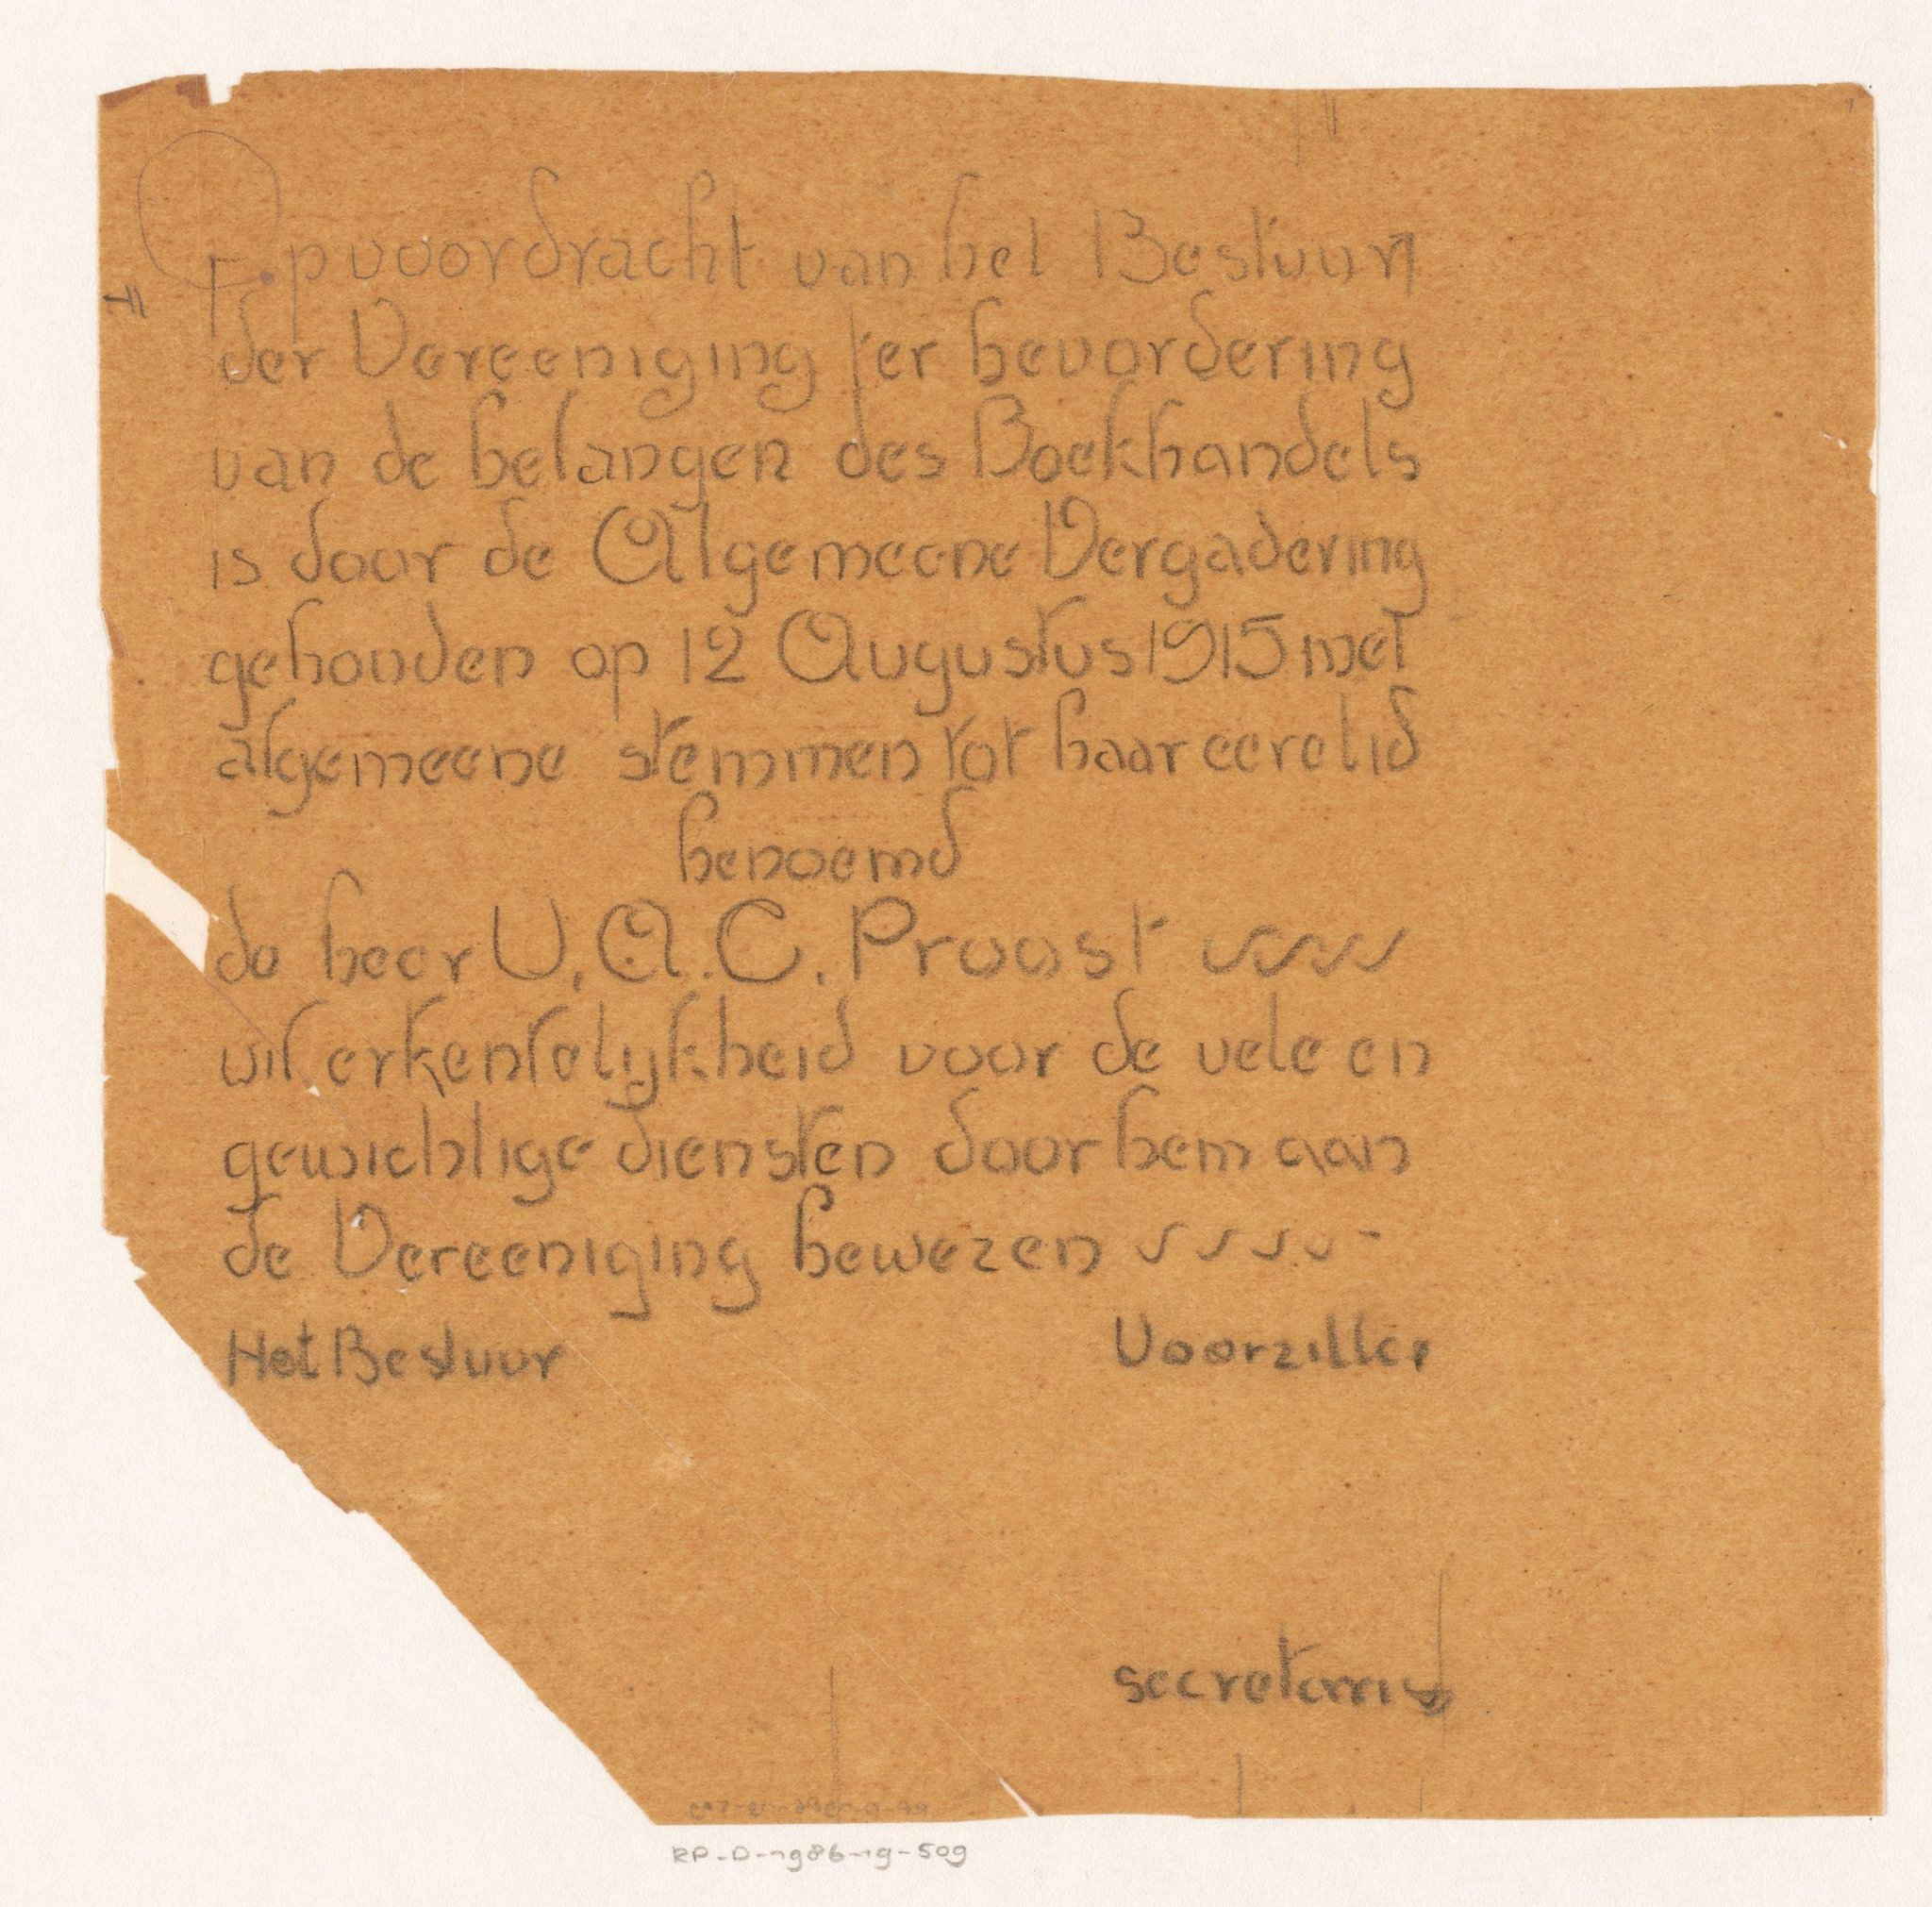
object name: design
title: Ontwerp voor een oorkonde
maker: reinier willem petrus de vries (1874-1953)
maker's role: draughtsman, print maker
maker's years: 1874-1953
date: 1915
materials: pencil, paper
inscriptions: date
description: Handgeschreven tekst betreffende de benoeming van de heer V.(W?) A.C. Proost als erelid van de Vereeniging ter bevordering van de belangen des Boekhandels.